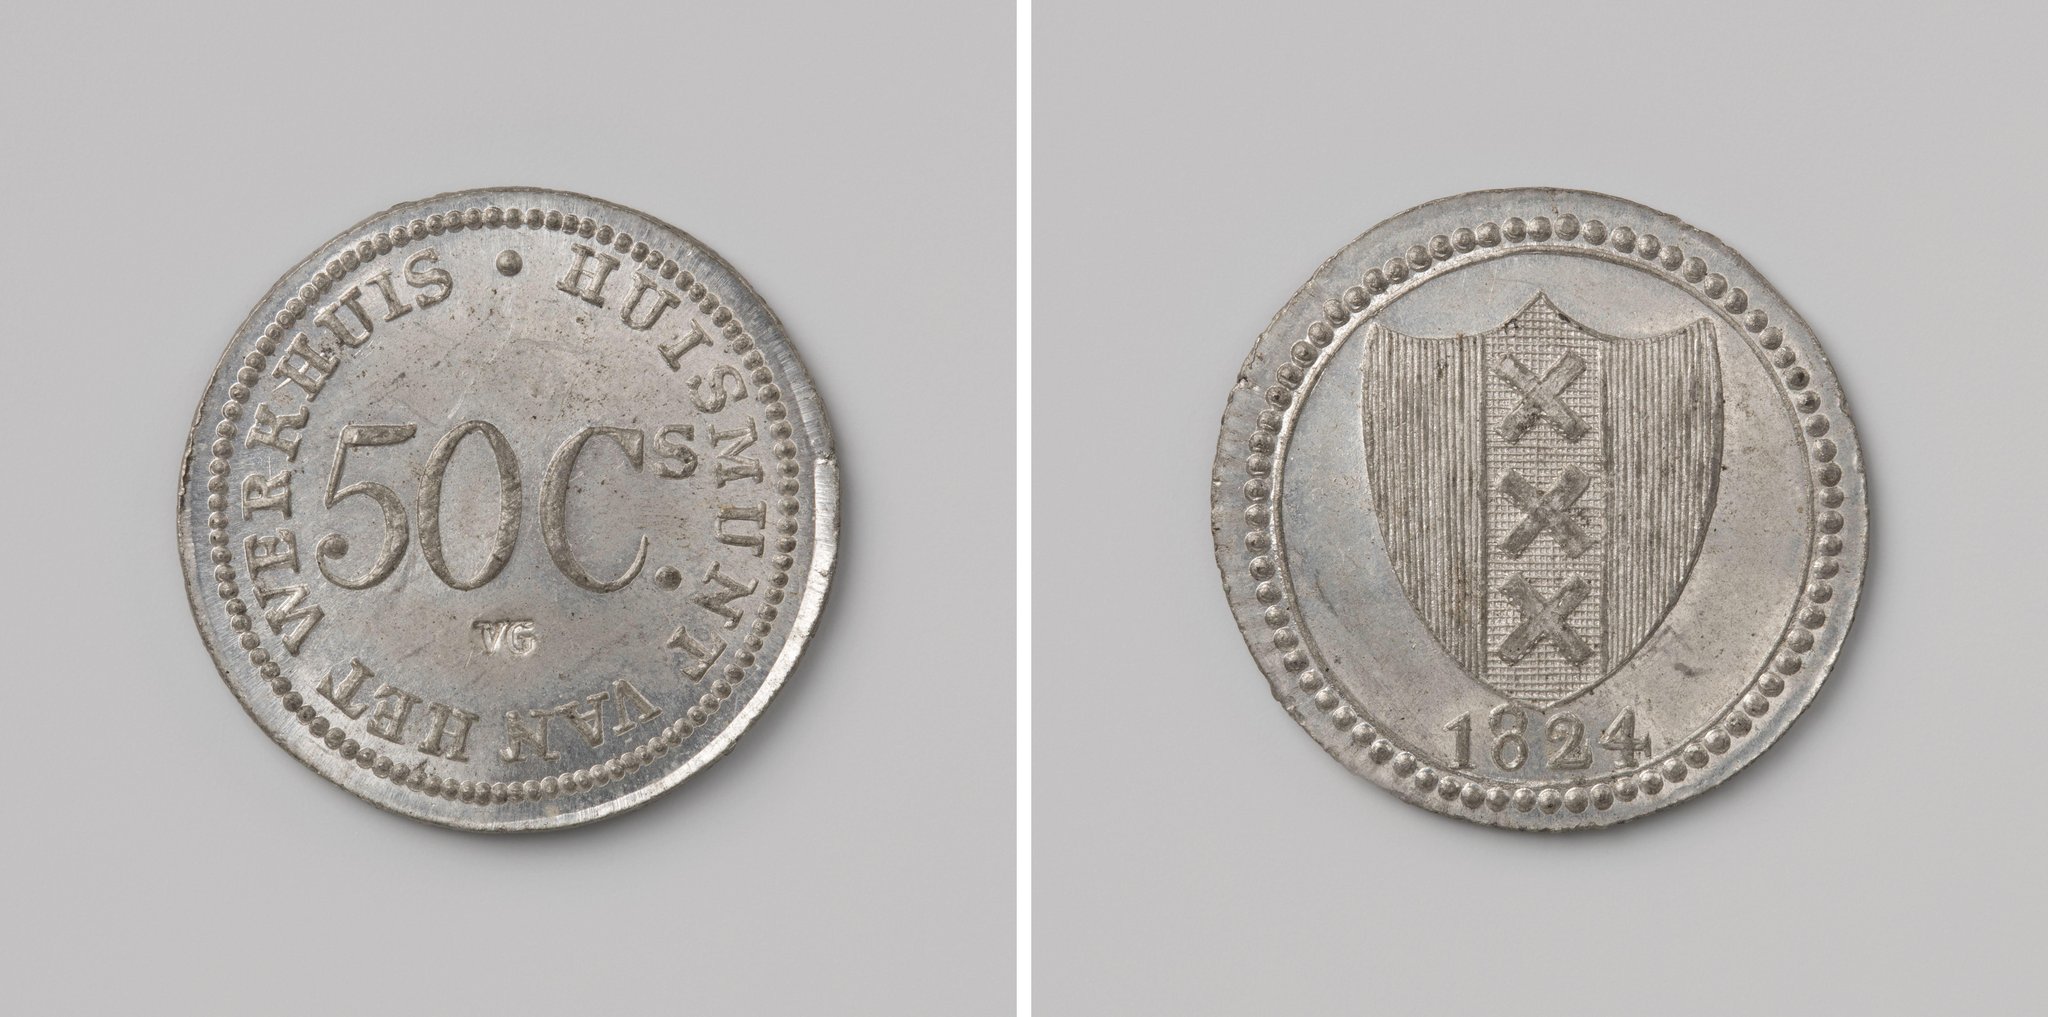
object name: vijftig cent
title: Huismunt ter waarde van vijftig cent, van het Werkhuis te Amsterdam, met stempel VG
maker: hendrik de heus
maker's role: medailleur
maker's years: -1838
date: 1824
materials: tin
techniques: striking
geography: amsterdam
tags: amsterdam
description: Voorzijde: waardeaanduiding binnen omschrift en parelrand; onder cijfer 50 klop: letters V en G. Keerzijde: wapenschild boven jaartal binnen parelrand